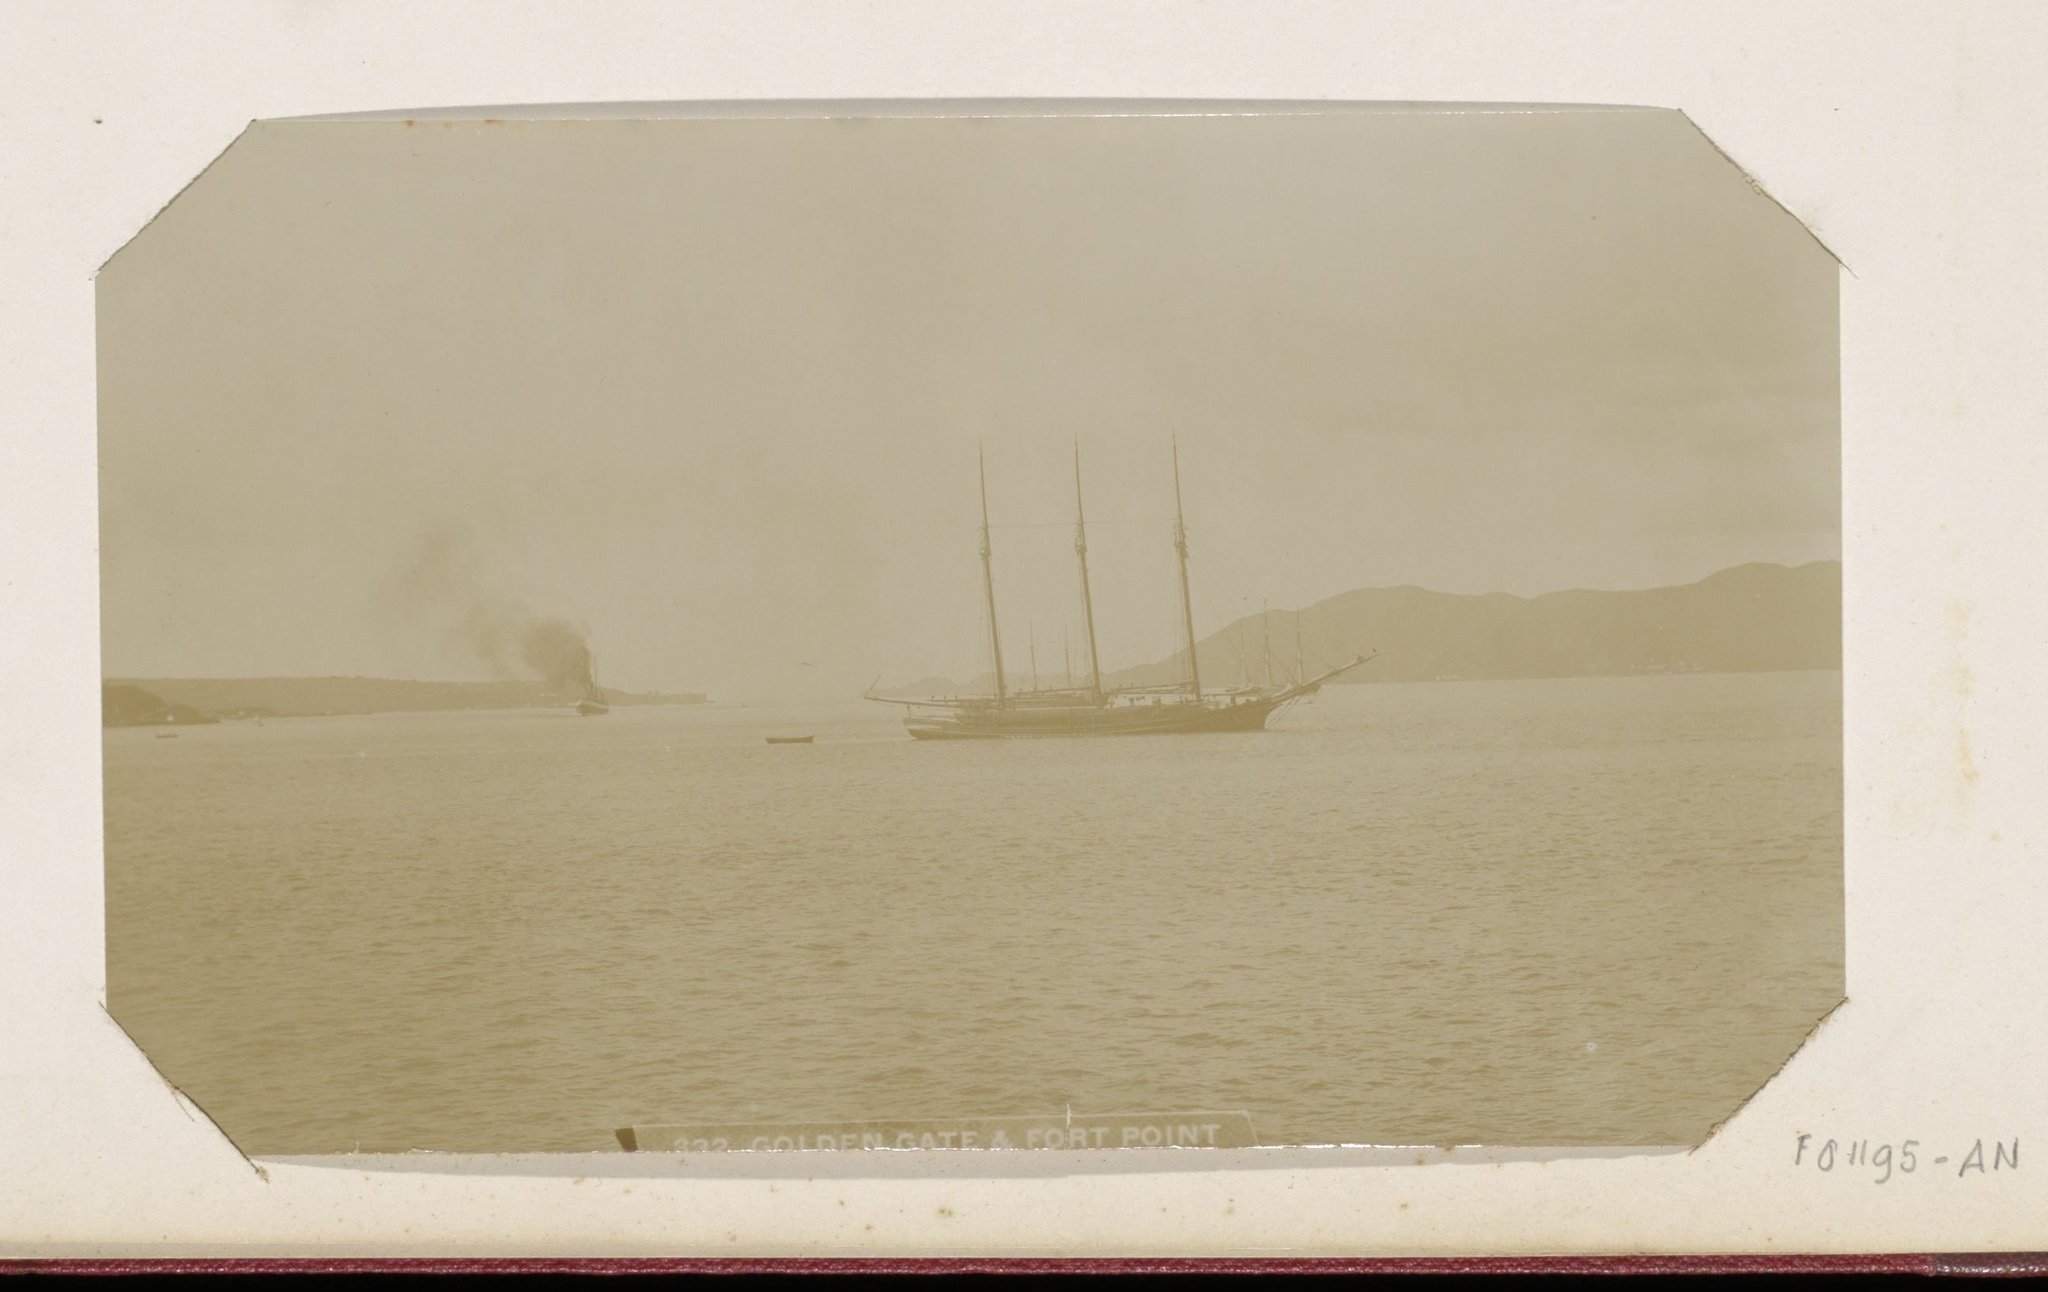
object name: photograph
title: Schepen bij de Golden Gate zeestraat en Fort Point in San Francisco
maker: Anonymous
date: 1860-1900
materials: cardboard, paper, photographic support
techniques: gelatin silver print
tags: sailing-ship, sailing-boat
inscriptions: negative number: ‘332’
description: Onderdeel van Fotoalbum van een reis door de Verenigde Staten, Honolulu, Nederlands-Indië, Aden, Zanzibar en Zuidelijk Afrika.